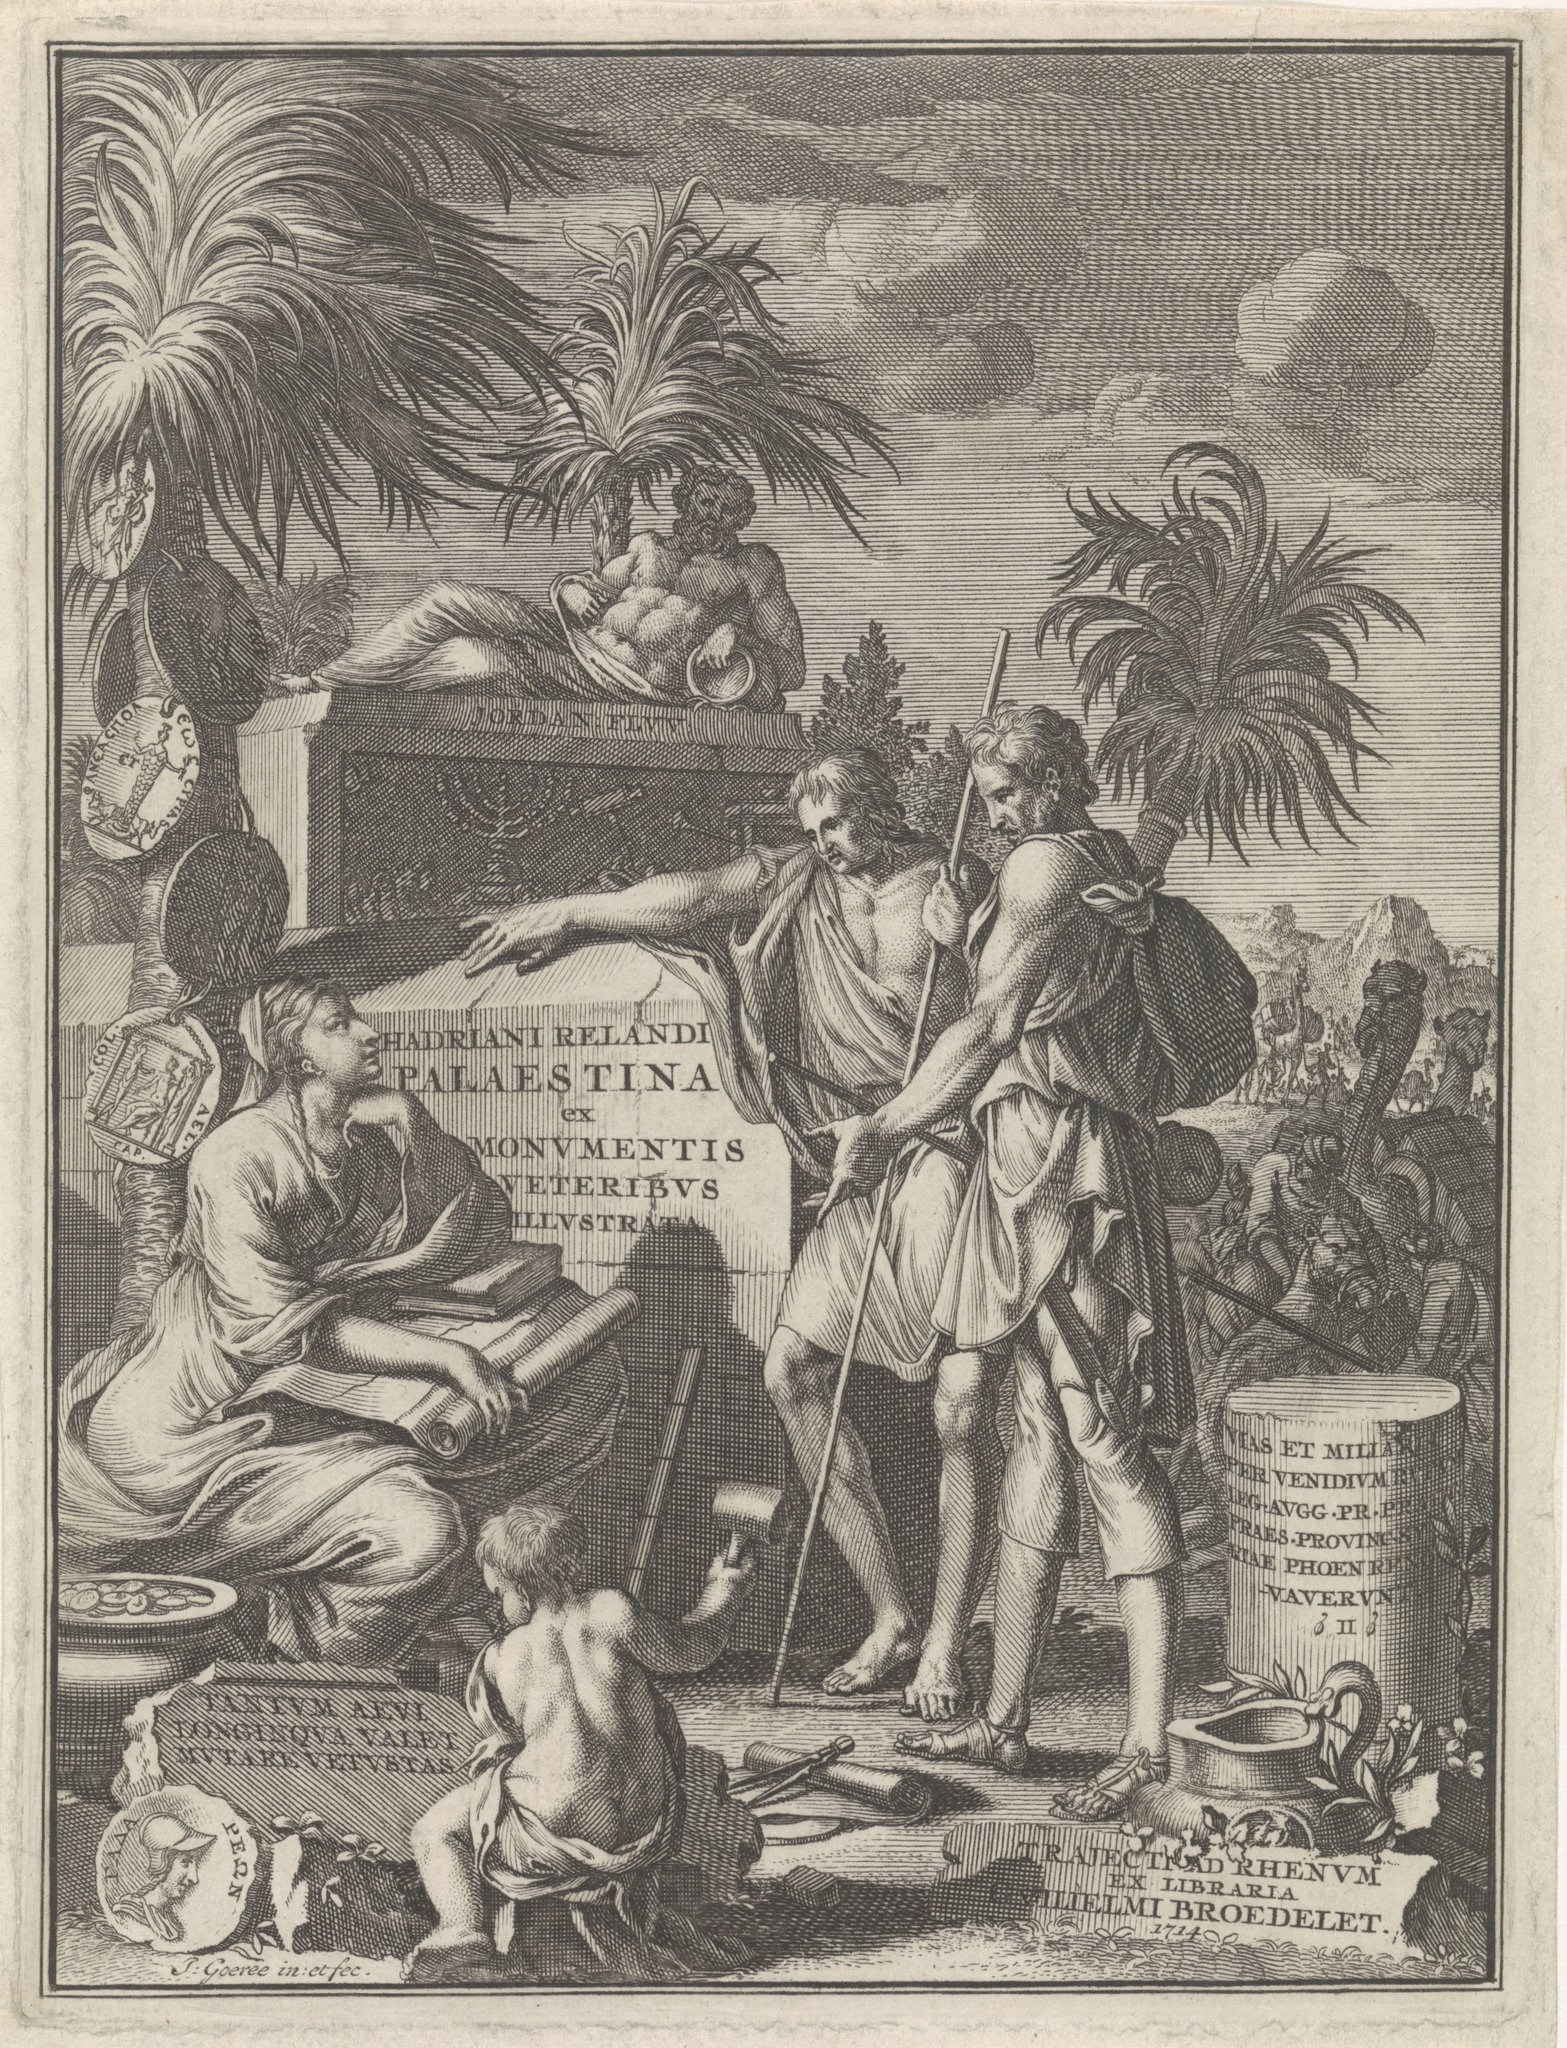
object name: print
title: Titelpagina voor Hadrianus Relandus, Palaestina ex monumentis veteribus illustrata, 1714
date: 1714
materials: paper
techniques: engraving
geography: utrecht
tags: hoofed animals: camel, landscape with ruins, events and situations from classical history, trees: palm-tree, mason at work, old testament, cupids: 'amores', 'amoretti', 'putti'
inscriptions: collector's mark: Lugt 2228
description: Twee Palestijnse herders praten met een zittende vrouw. Rondom hen klassieke ruïnes. Op een ruïne naast de twee herders de titel van het boekwerk. Op de voorgrond beitelt een putto in een stuk steen. Op de achtergrond kamelen en palmbomen.